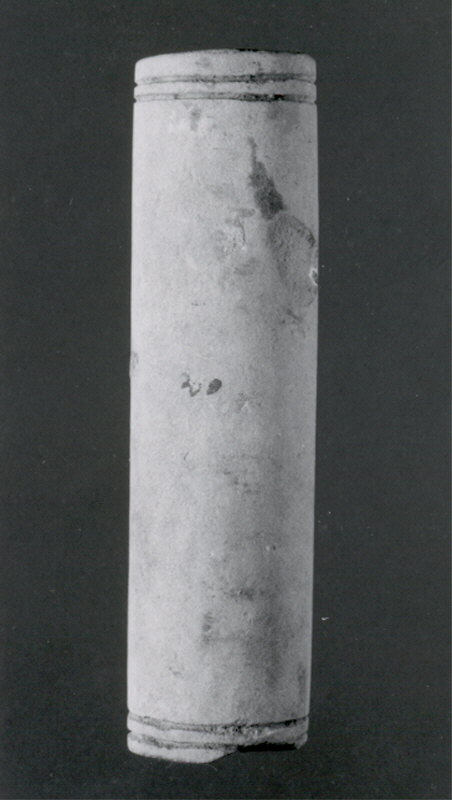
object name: bead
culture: iranian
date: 900-801 BCE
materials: glass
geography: iran